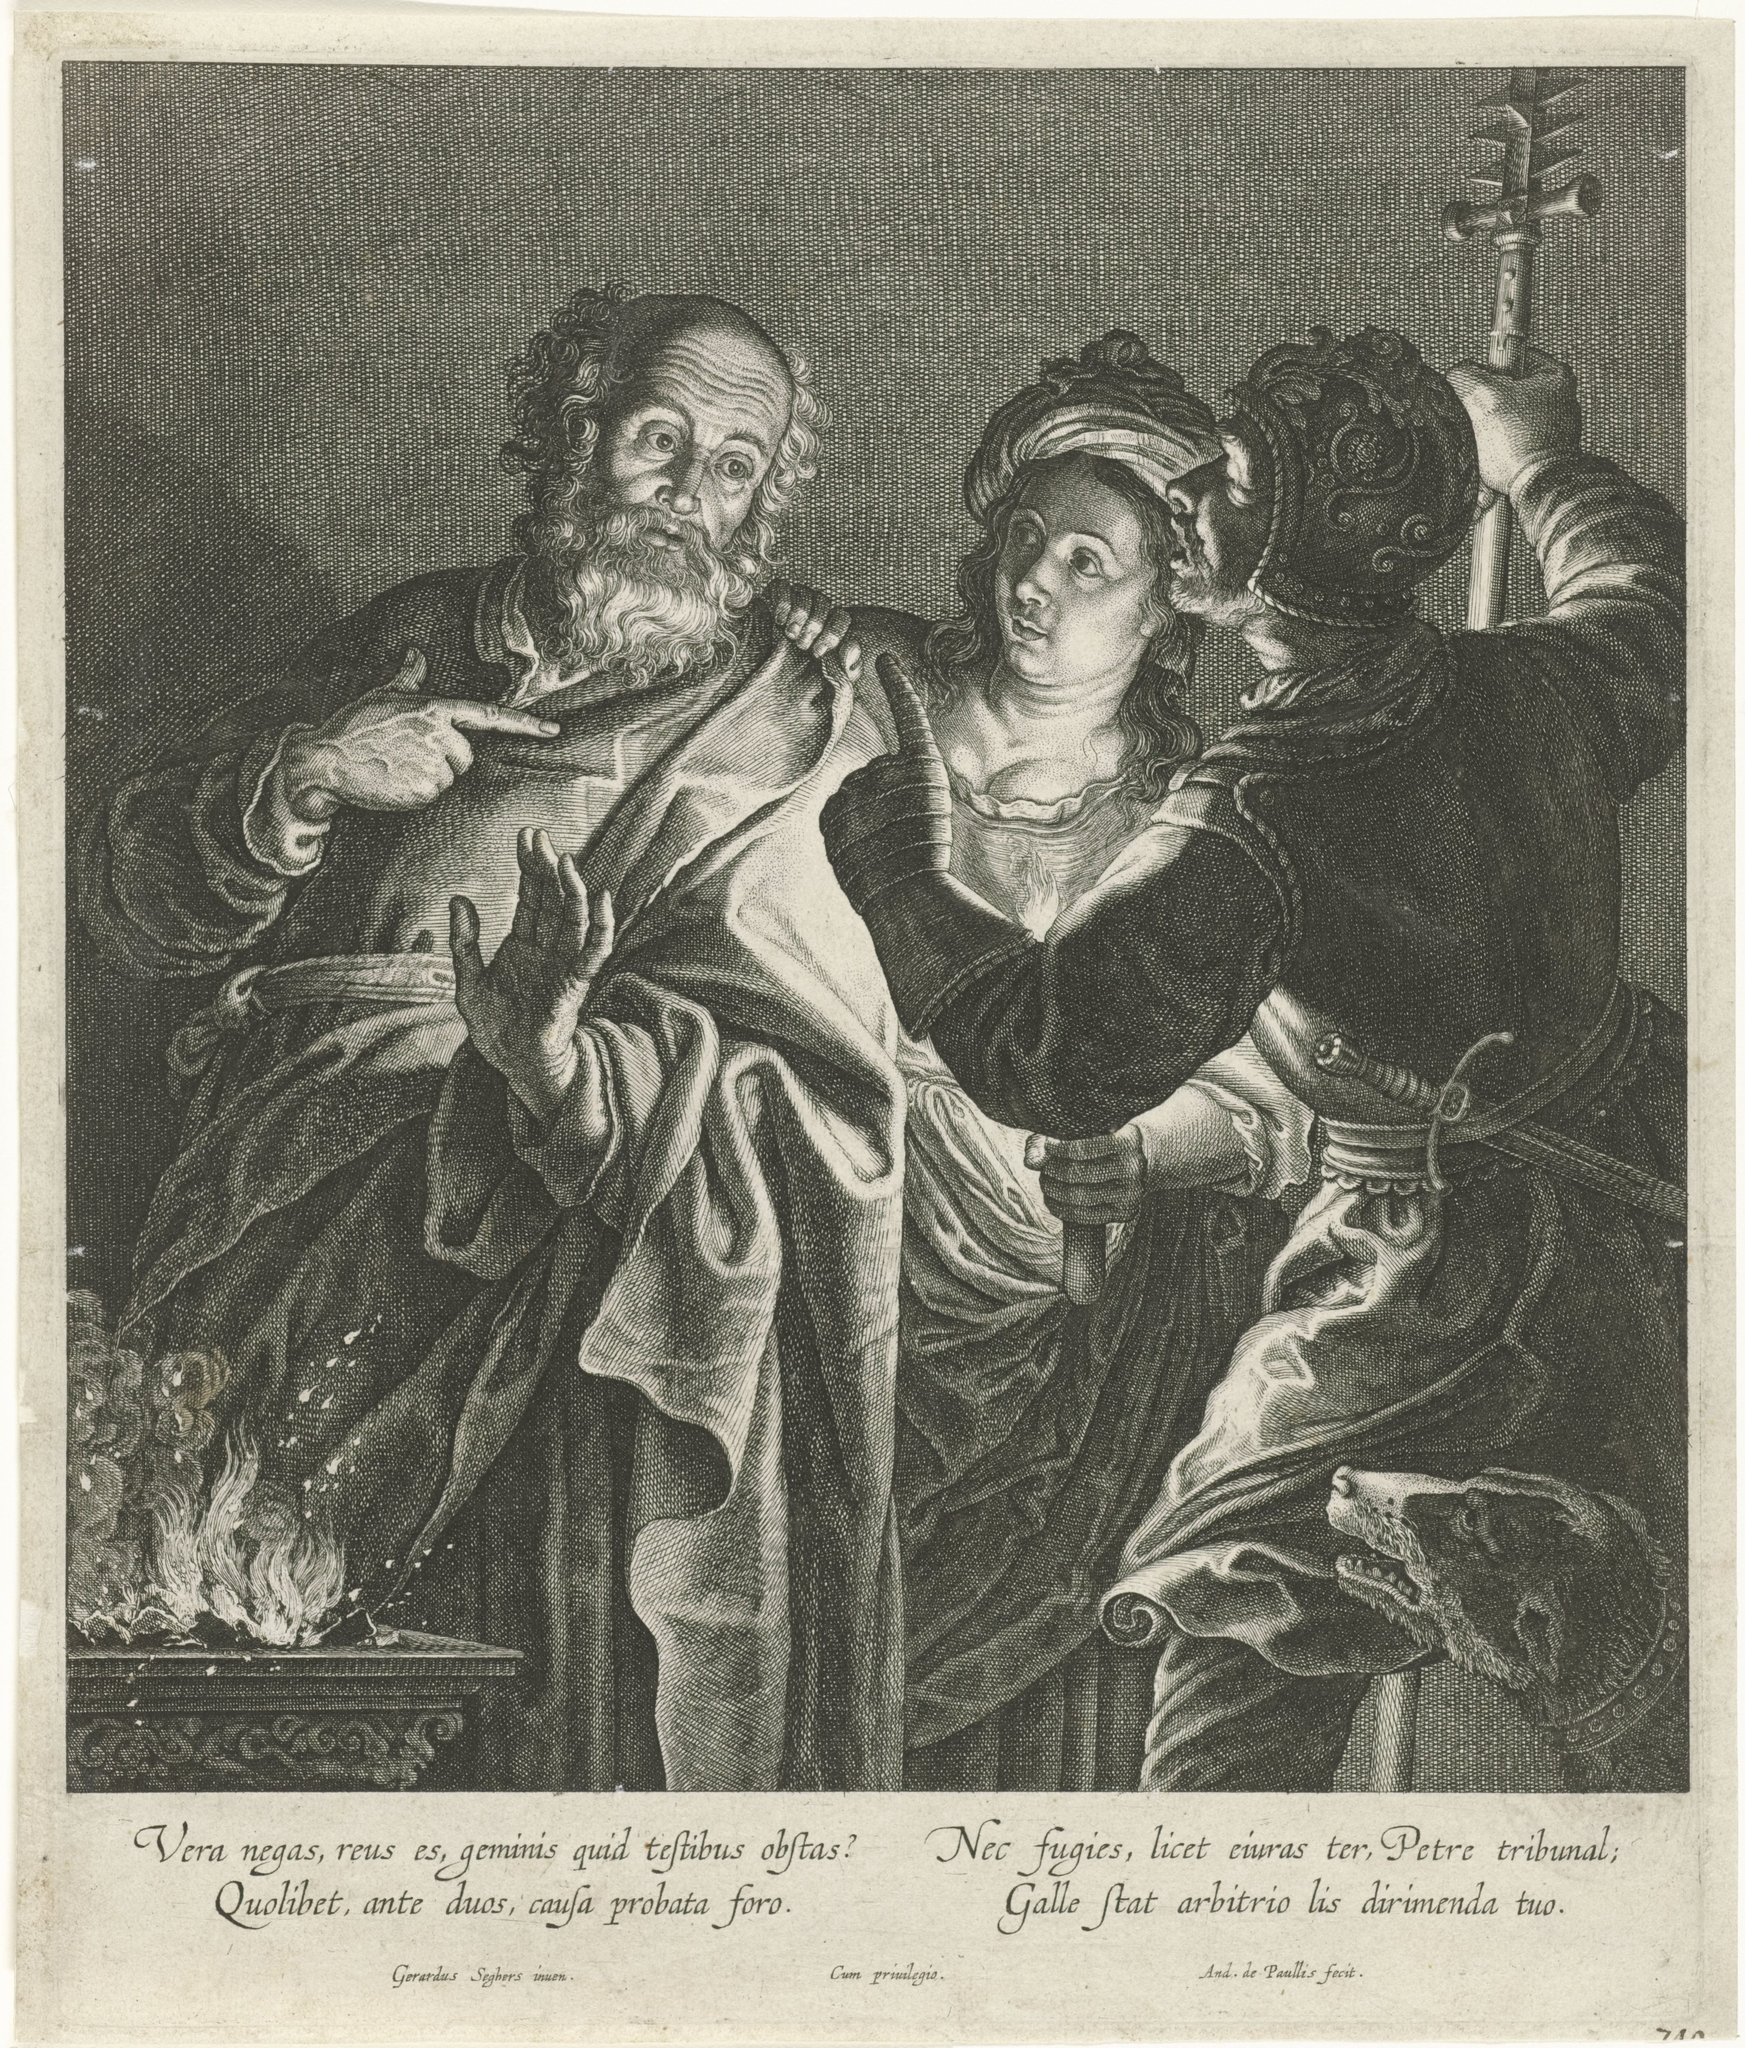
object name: print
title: De verloochening van Petrus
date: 1610-1639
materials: paper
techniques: engraving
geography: antwerp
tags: peter denies christ, usually before a girl-servant and some soldiers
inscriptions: number, collector's mark: Lugt 240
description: Een dienares van Kajafas herkent Petrus als volgeling van Christus, maar Petrus ontkent dit. In de marge een vierregelig onderschrift, in twee kolommen, in het Latijn.